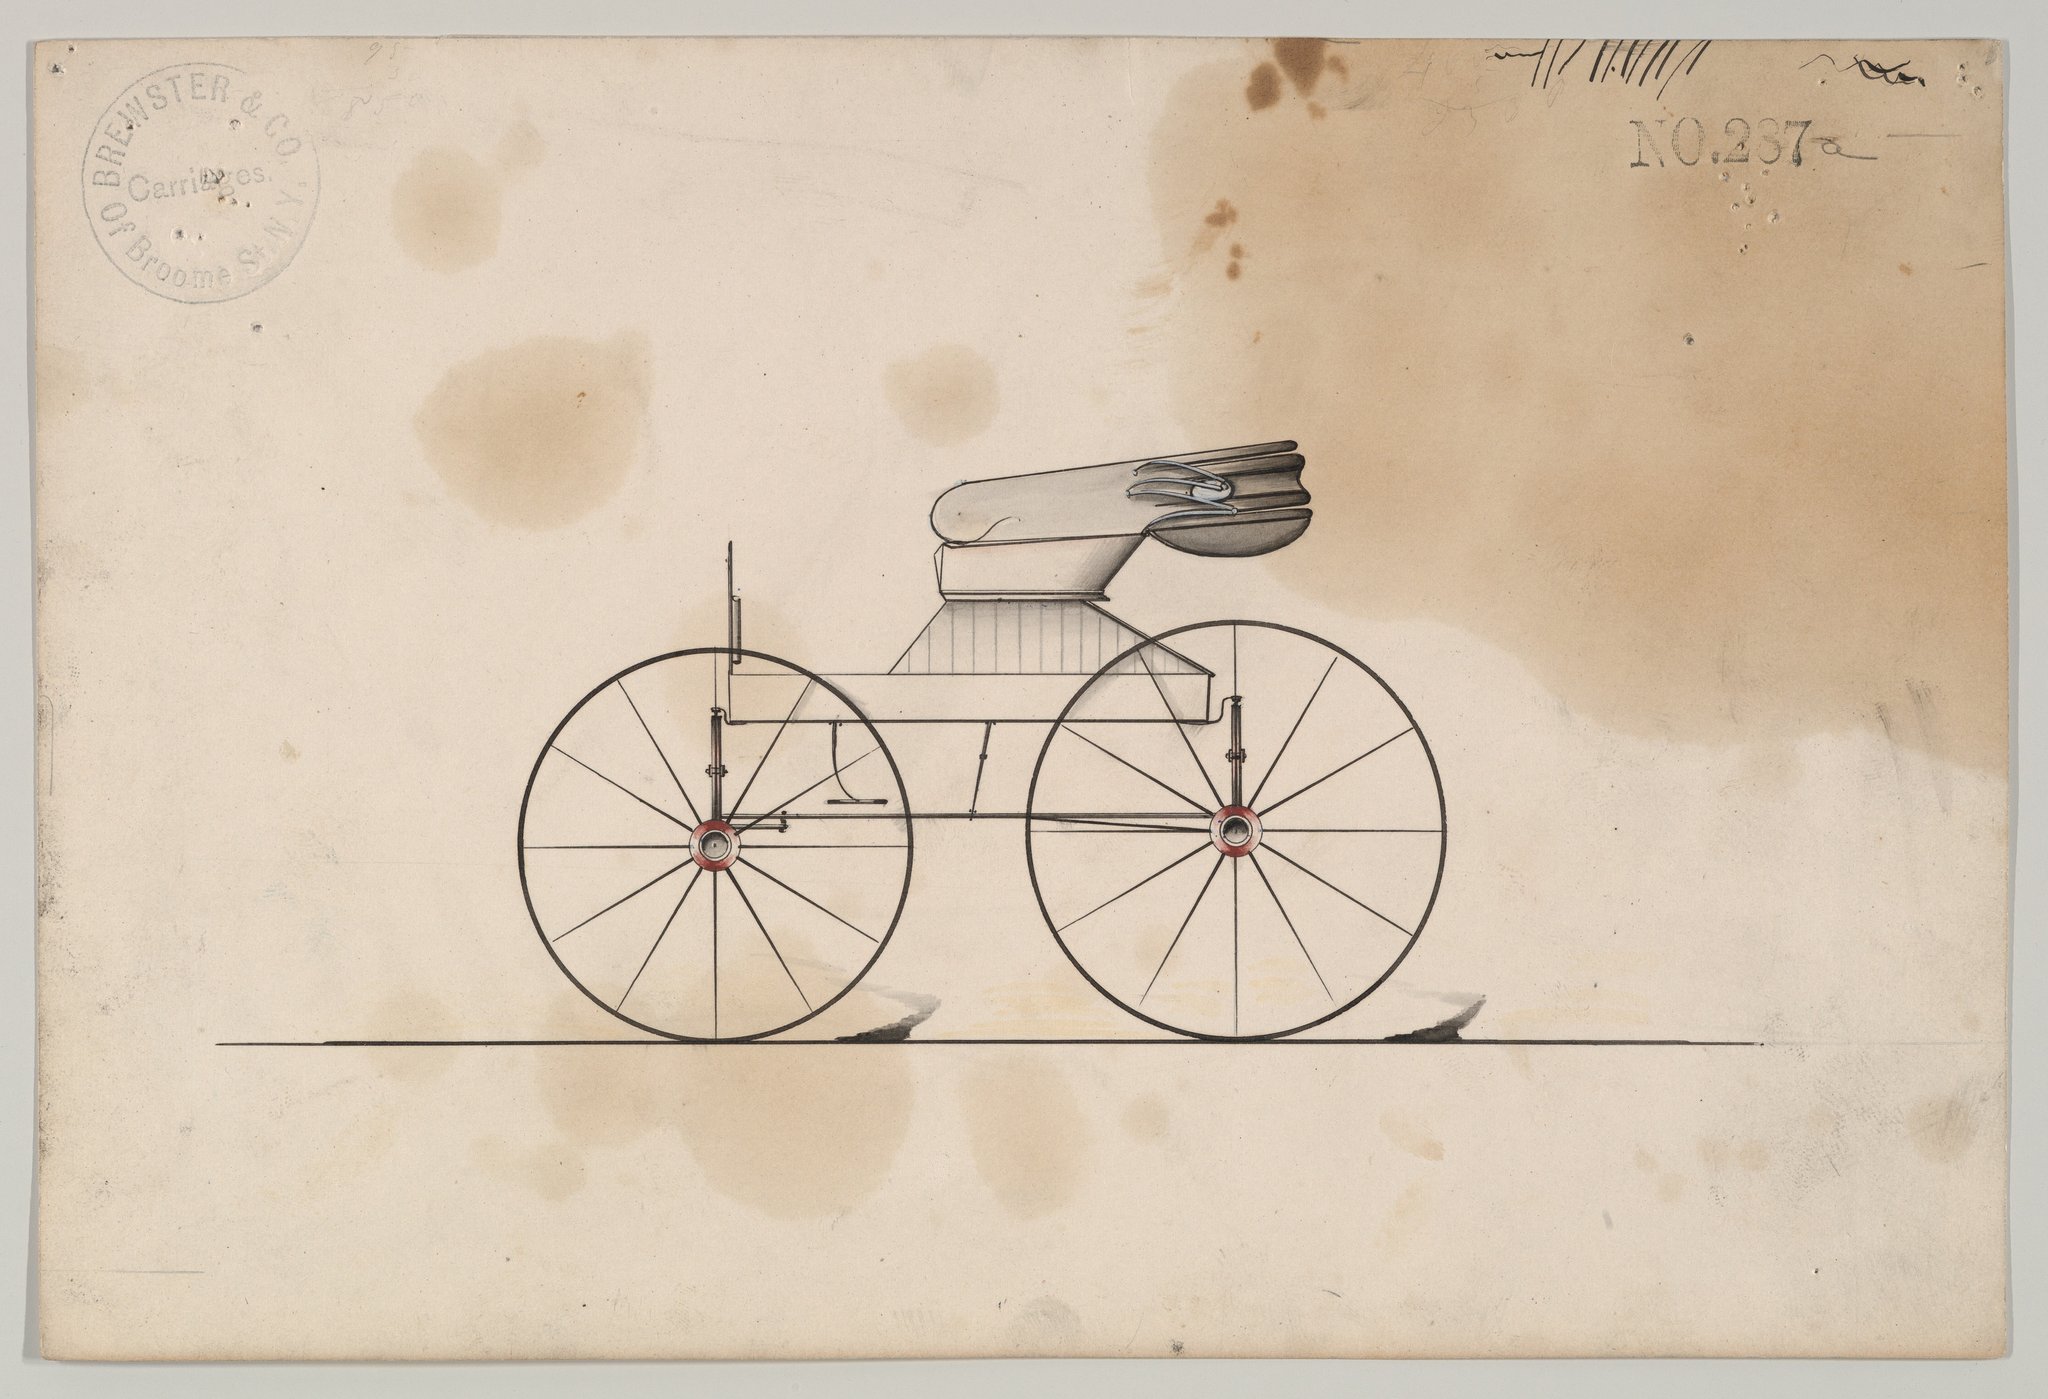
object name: drawing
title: Design for Wagon, no. 287a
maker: brewster & co.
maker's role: manufacturer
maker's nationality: american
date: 1865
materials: ink, watercolor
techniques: pen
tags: carriages